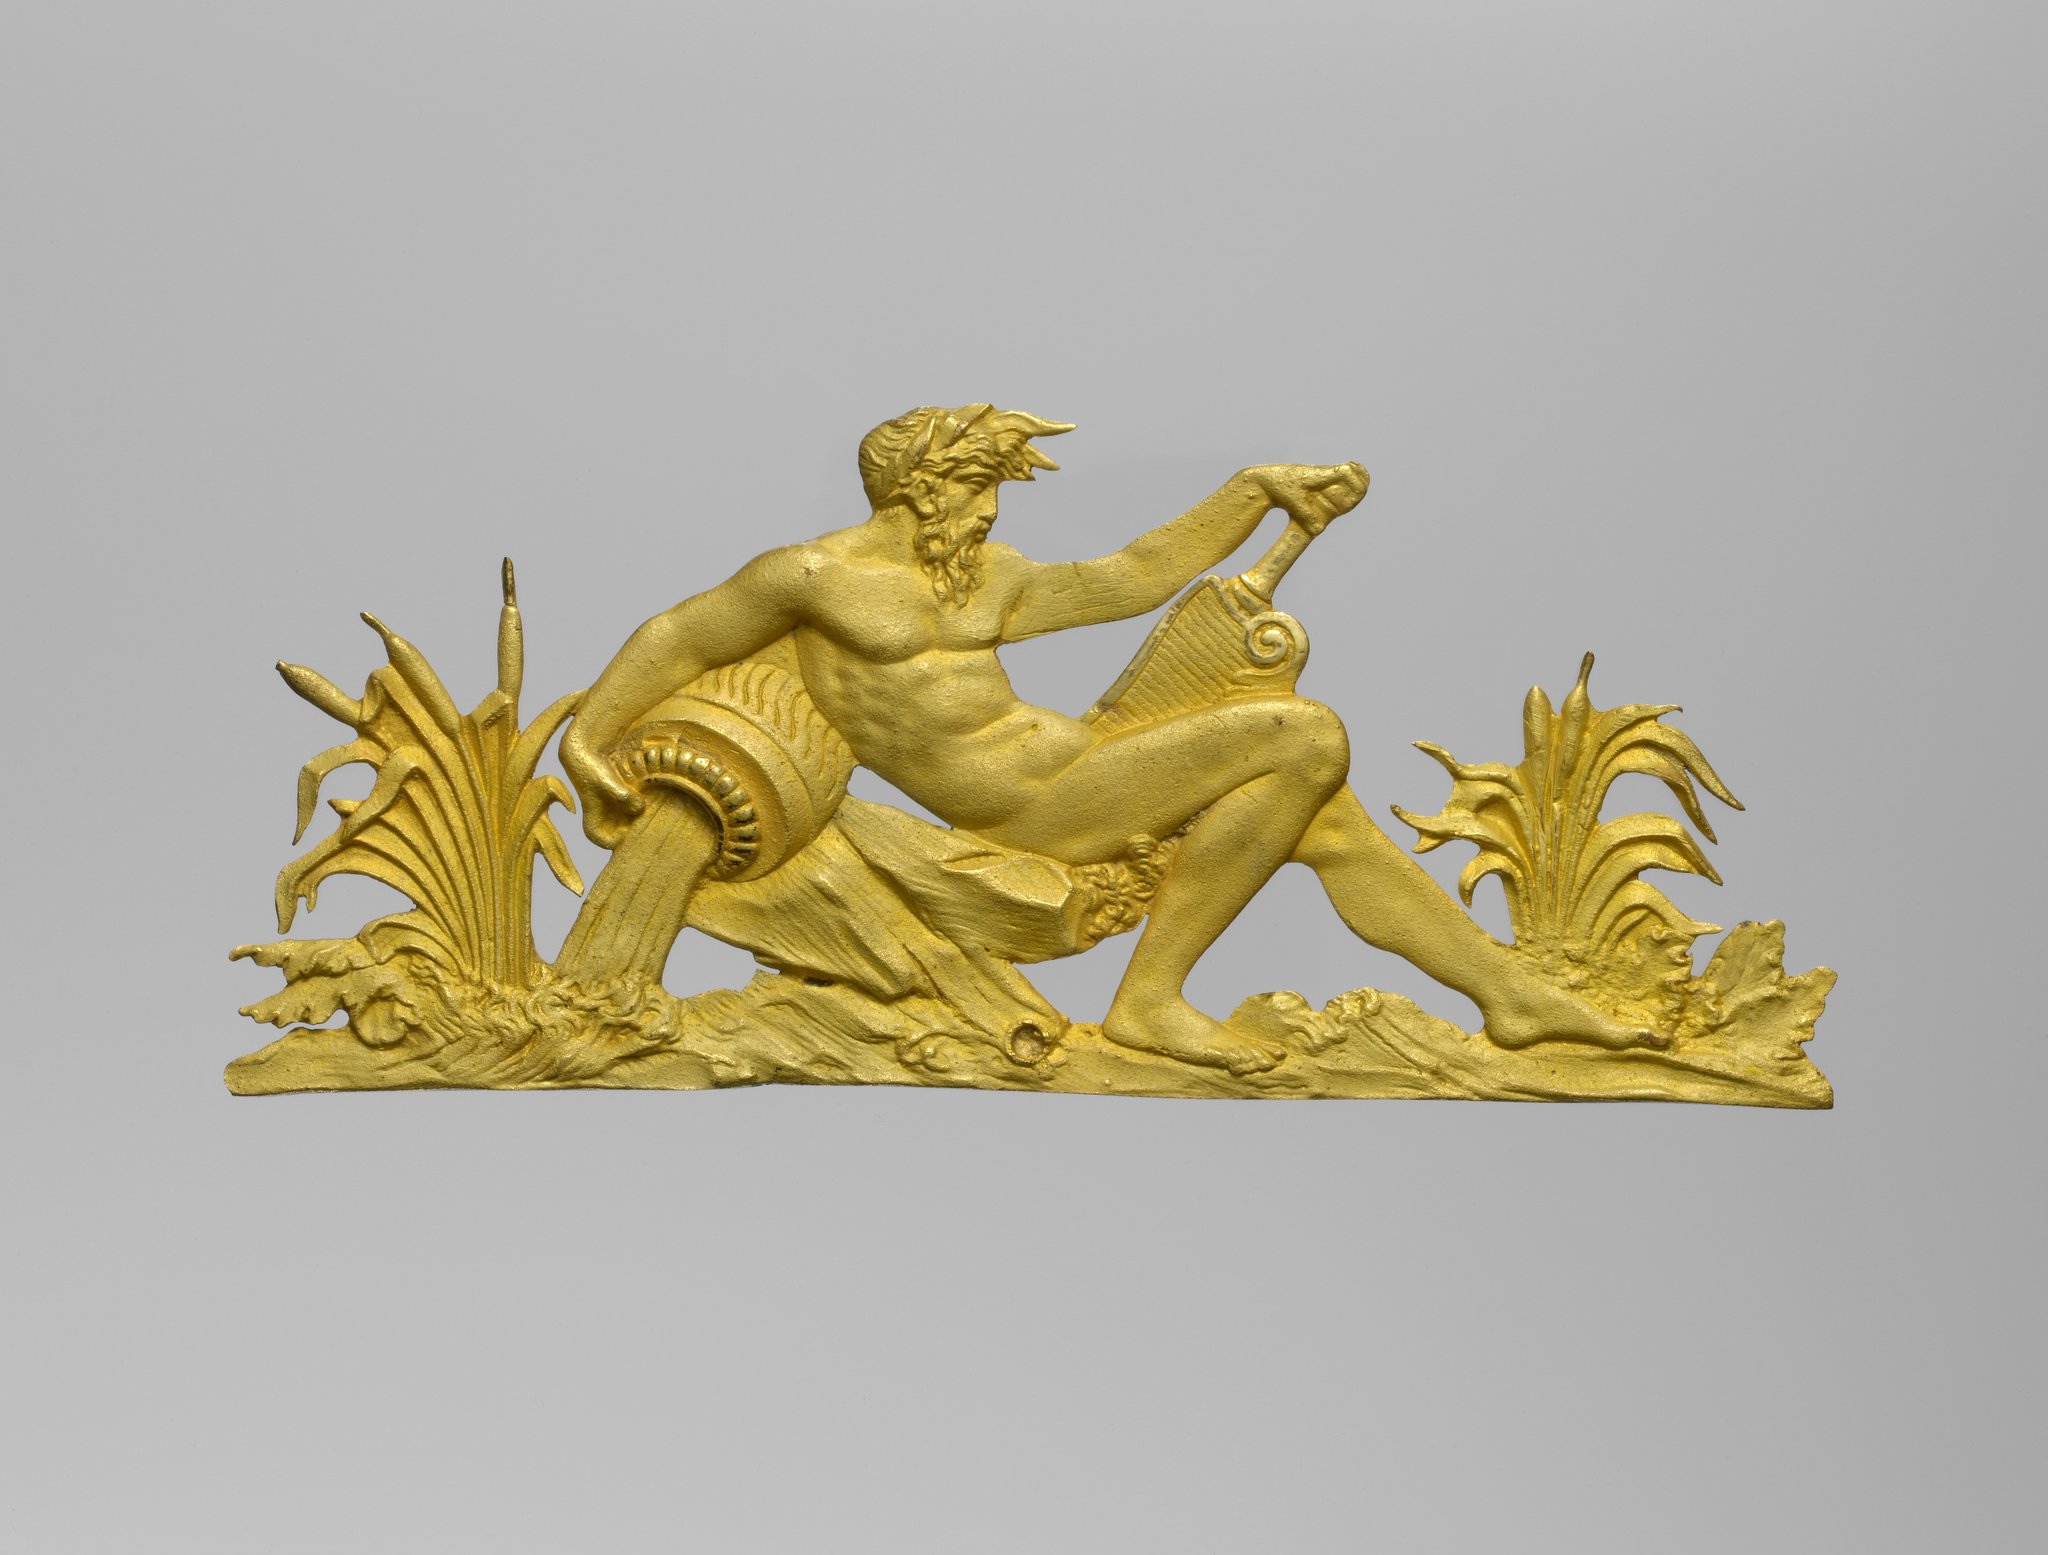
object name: appliqué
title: River God Appliqué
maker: henry kellam hancock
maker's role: retailer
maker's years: 1816-1851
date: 1810-1830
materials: brass, gold, mercury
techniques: casting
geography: france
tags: male nudes